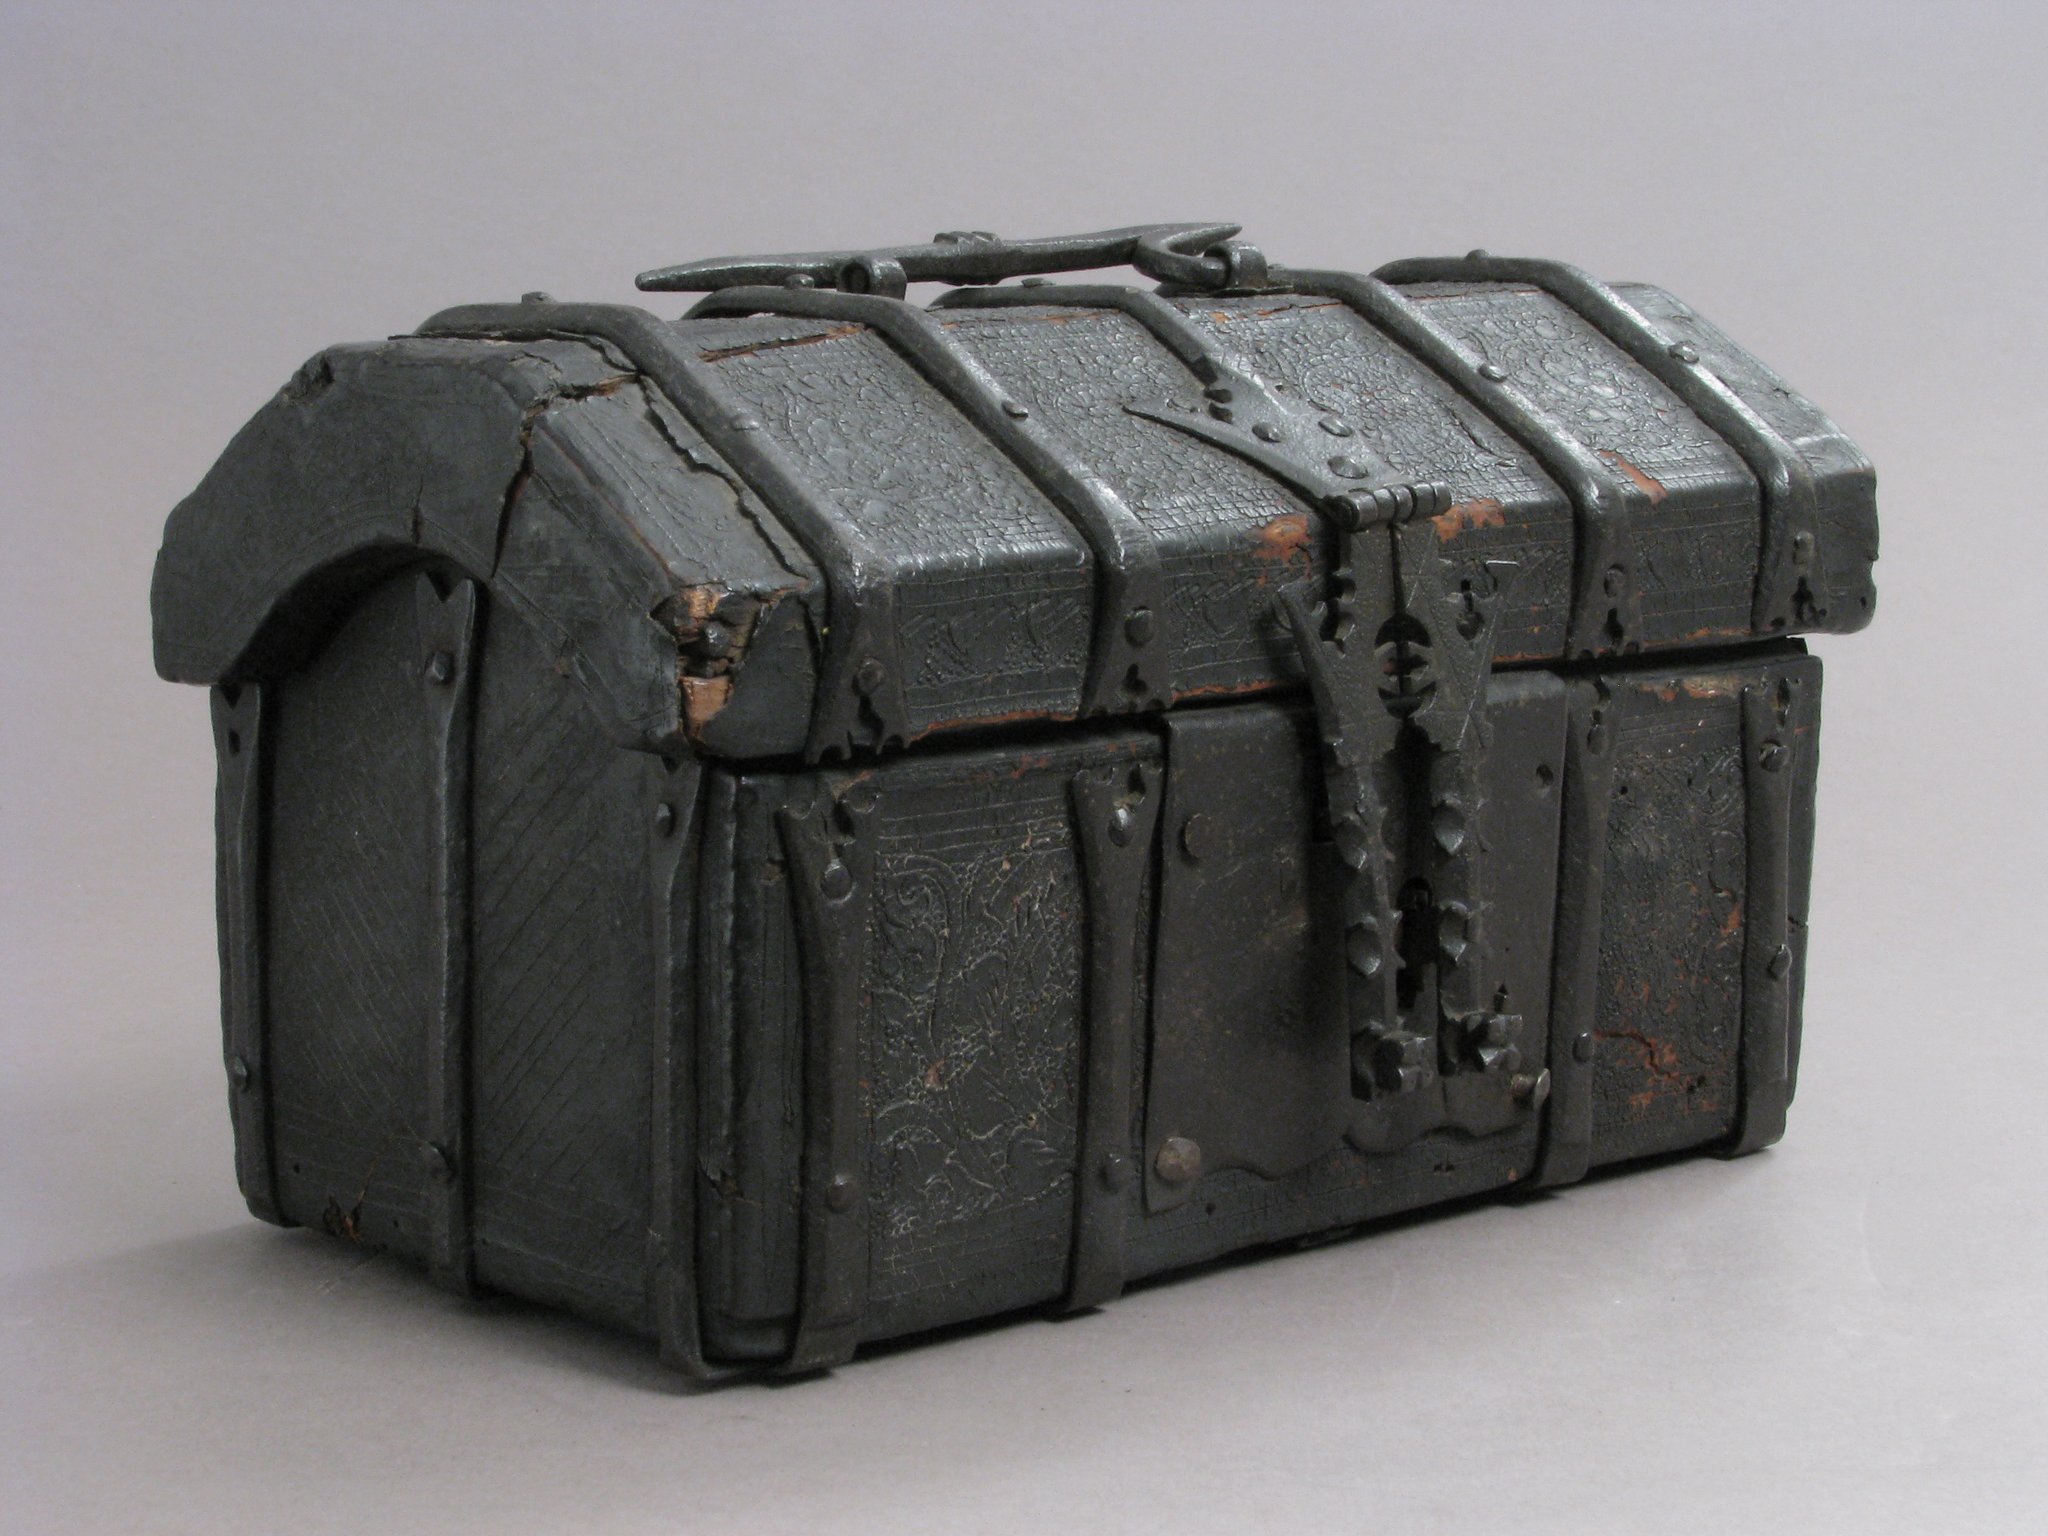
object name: coffer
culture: north french or south netherlandish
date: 1467-1500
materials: iron, wood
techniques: tooling